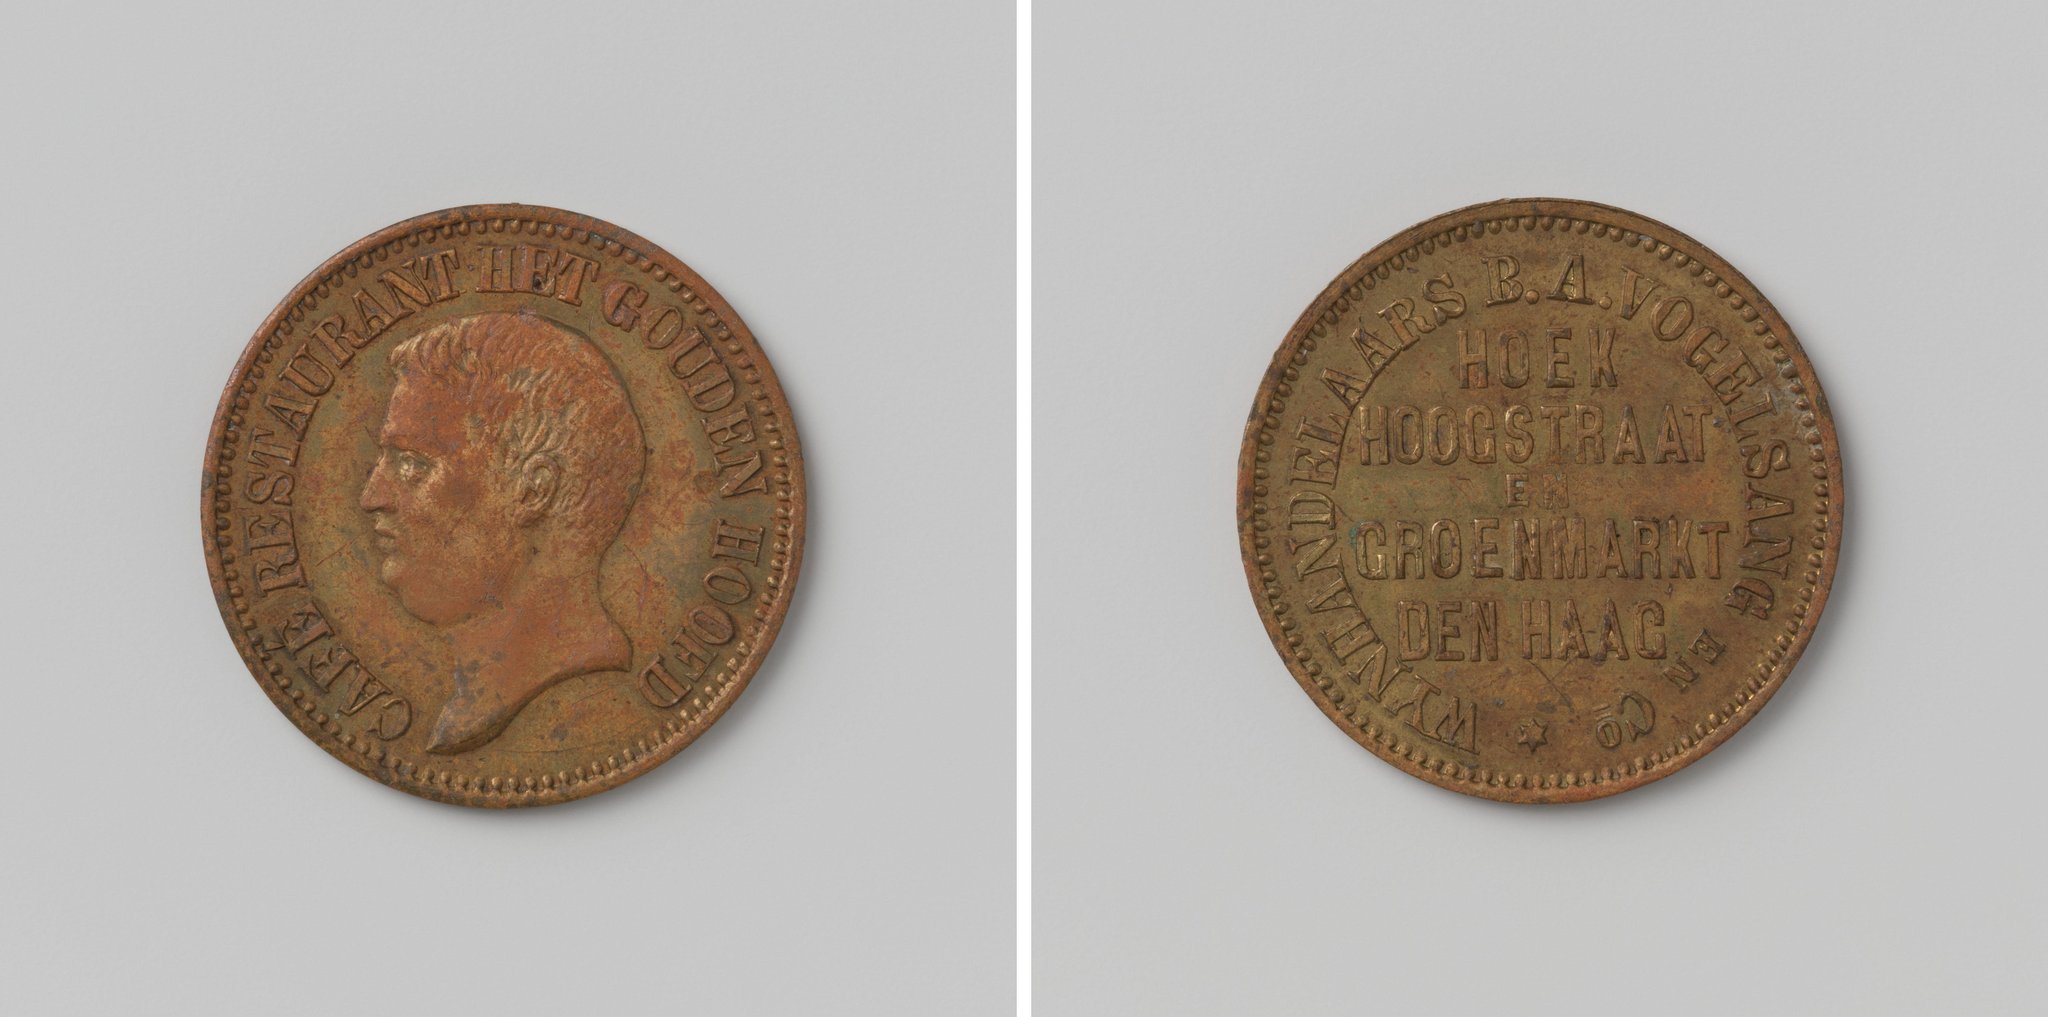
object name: adrespenning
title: Opening van Cafe-restaurant Het Gouden Hoofd, adrespenning van B.A. Vogelsang & Co., wijnhandelaars aan de hoek Hoogstraat en Groenmarkt te 's-Gravenhage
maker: Anonymous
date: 1886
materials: brass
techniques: striking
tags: b.a. vogelsang, dagelijkse groenmarkt, hoogstraat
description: Messing penning. Voorzijde: naar links gewend hoofd binnen omschrift. Keerzijde: opschrift binnen omschrift